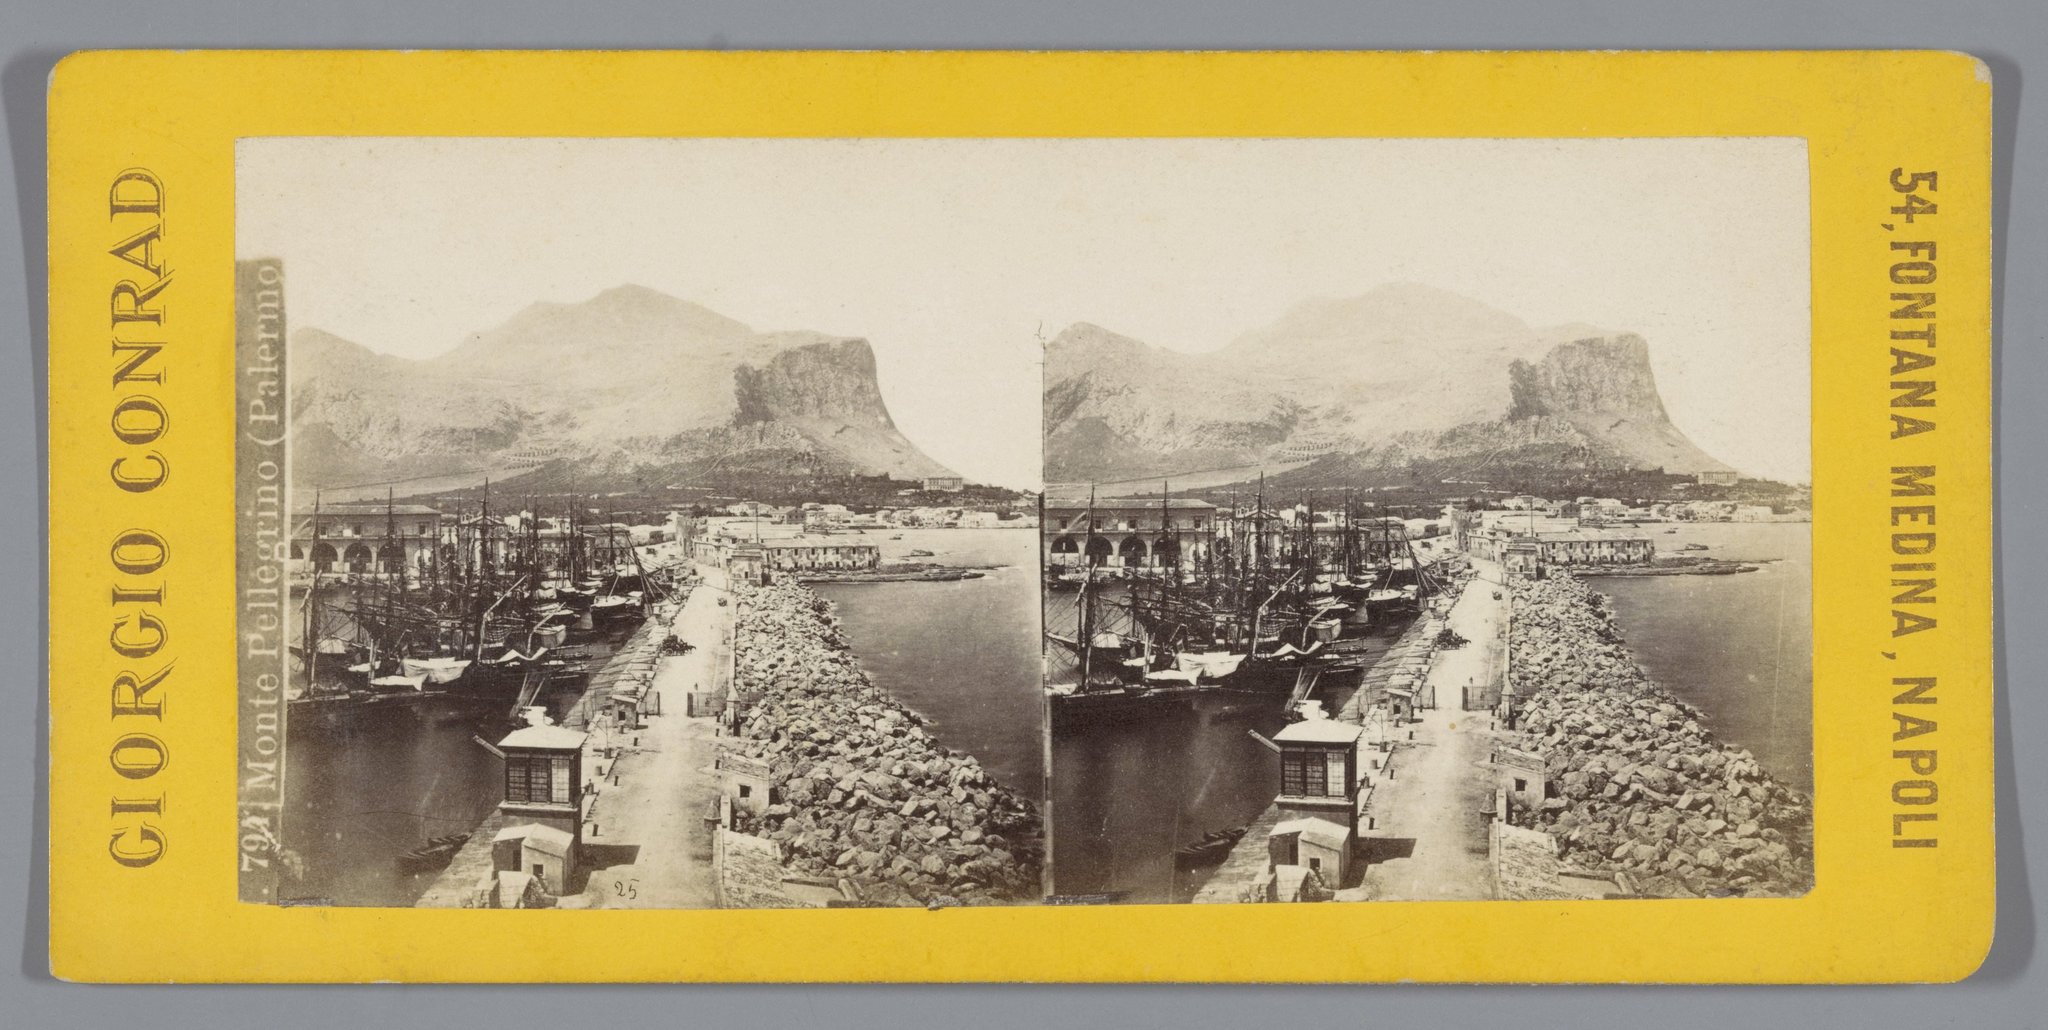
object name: stereograph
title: Haven van Palermo, met op de achtergrond de Monte Pellegrino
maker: giorgio conrad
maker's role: fotograaf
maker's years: 1827-1889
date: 1850-1870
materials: cardboard, photographic support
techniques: albumen print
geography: palermo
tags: harbour, mountains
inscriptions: name: ‘GIORGIO CONRAD 54, FONTANA MEDINA, NAPOLI’, number: ‘794’